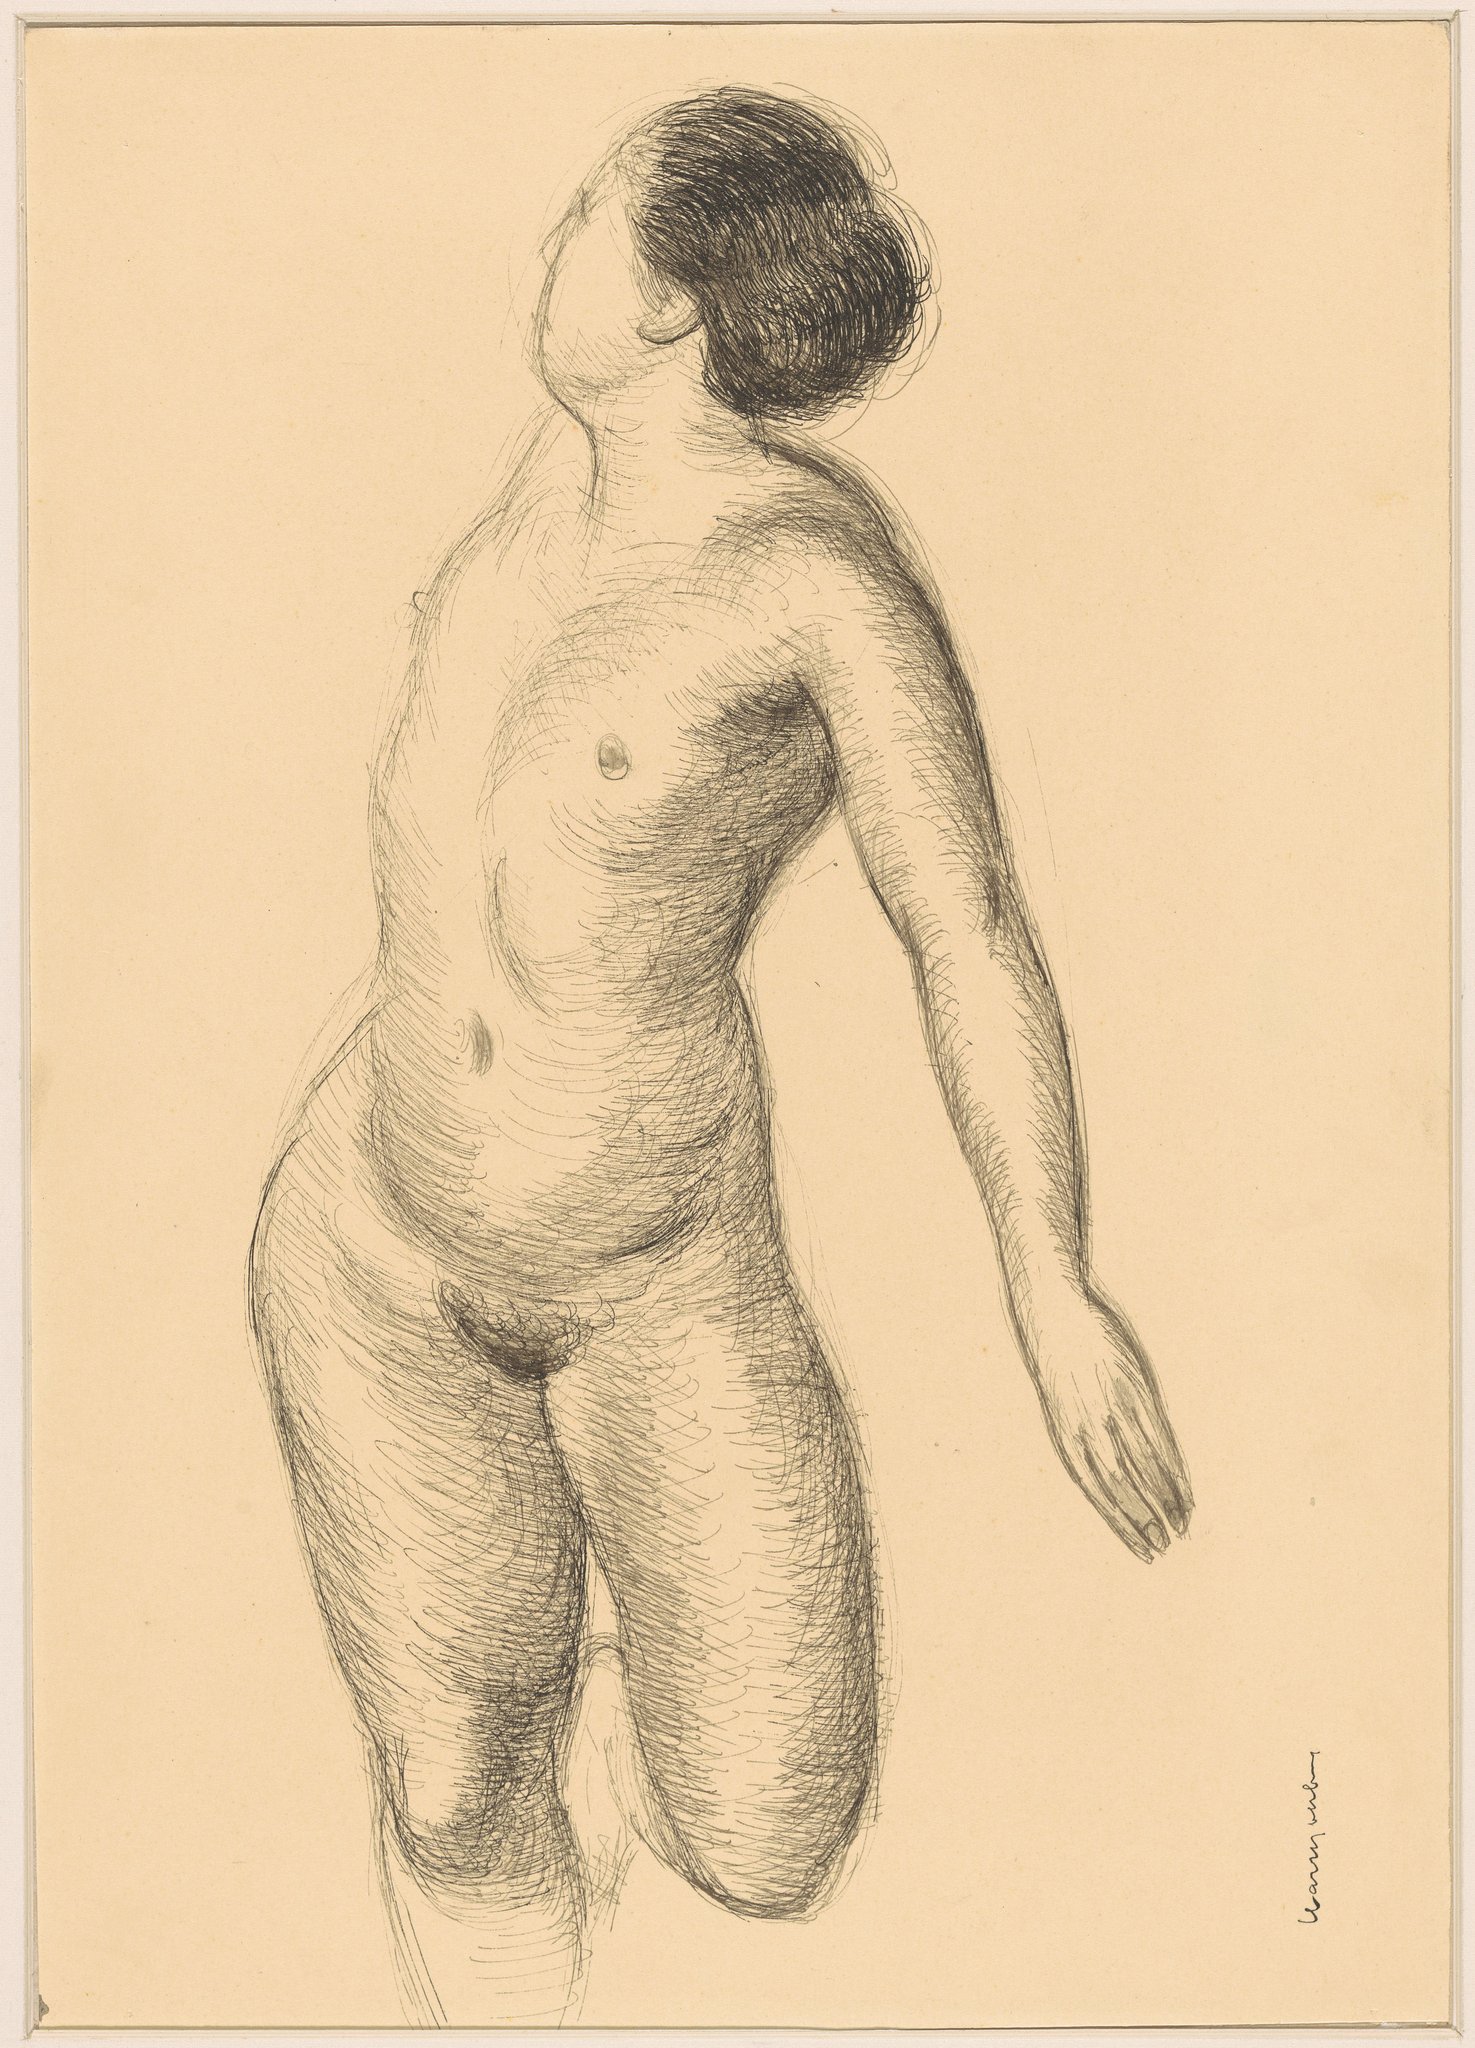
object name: drawing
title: Liggende naakte vrouw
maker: harrie verburg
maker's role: draughtsman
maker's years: 1914-1986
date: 1924-1947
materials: ink, paper, pencil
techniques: pen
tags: human figure of ideal proportions, e.g. academic nude - aa - female human figure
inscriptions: collector's mark: Lugt 2228